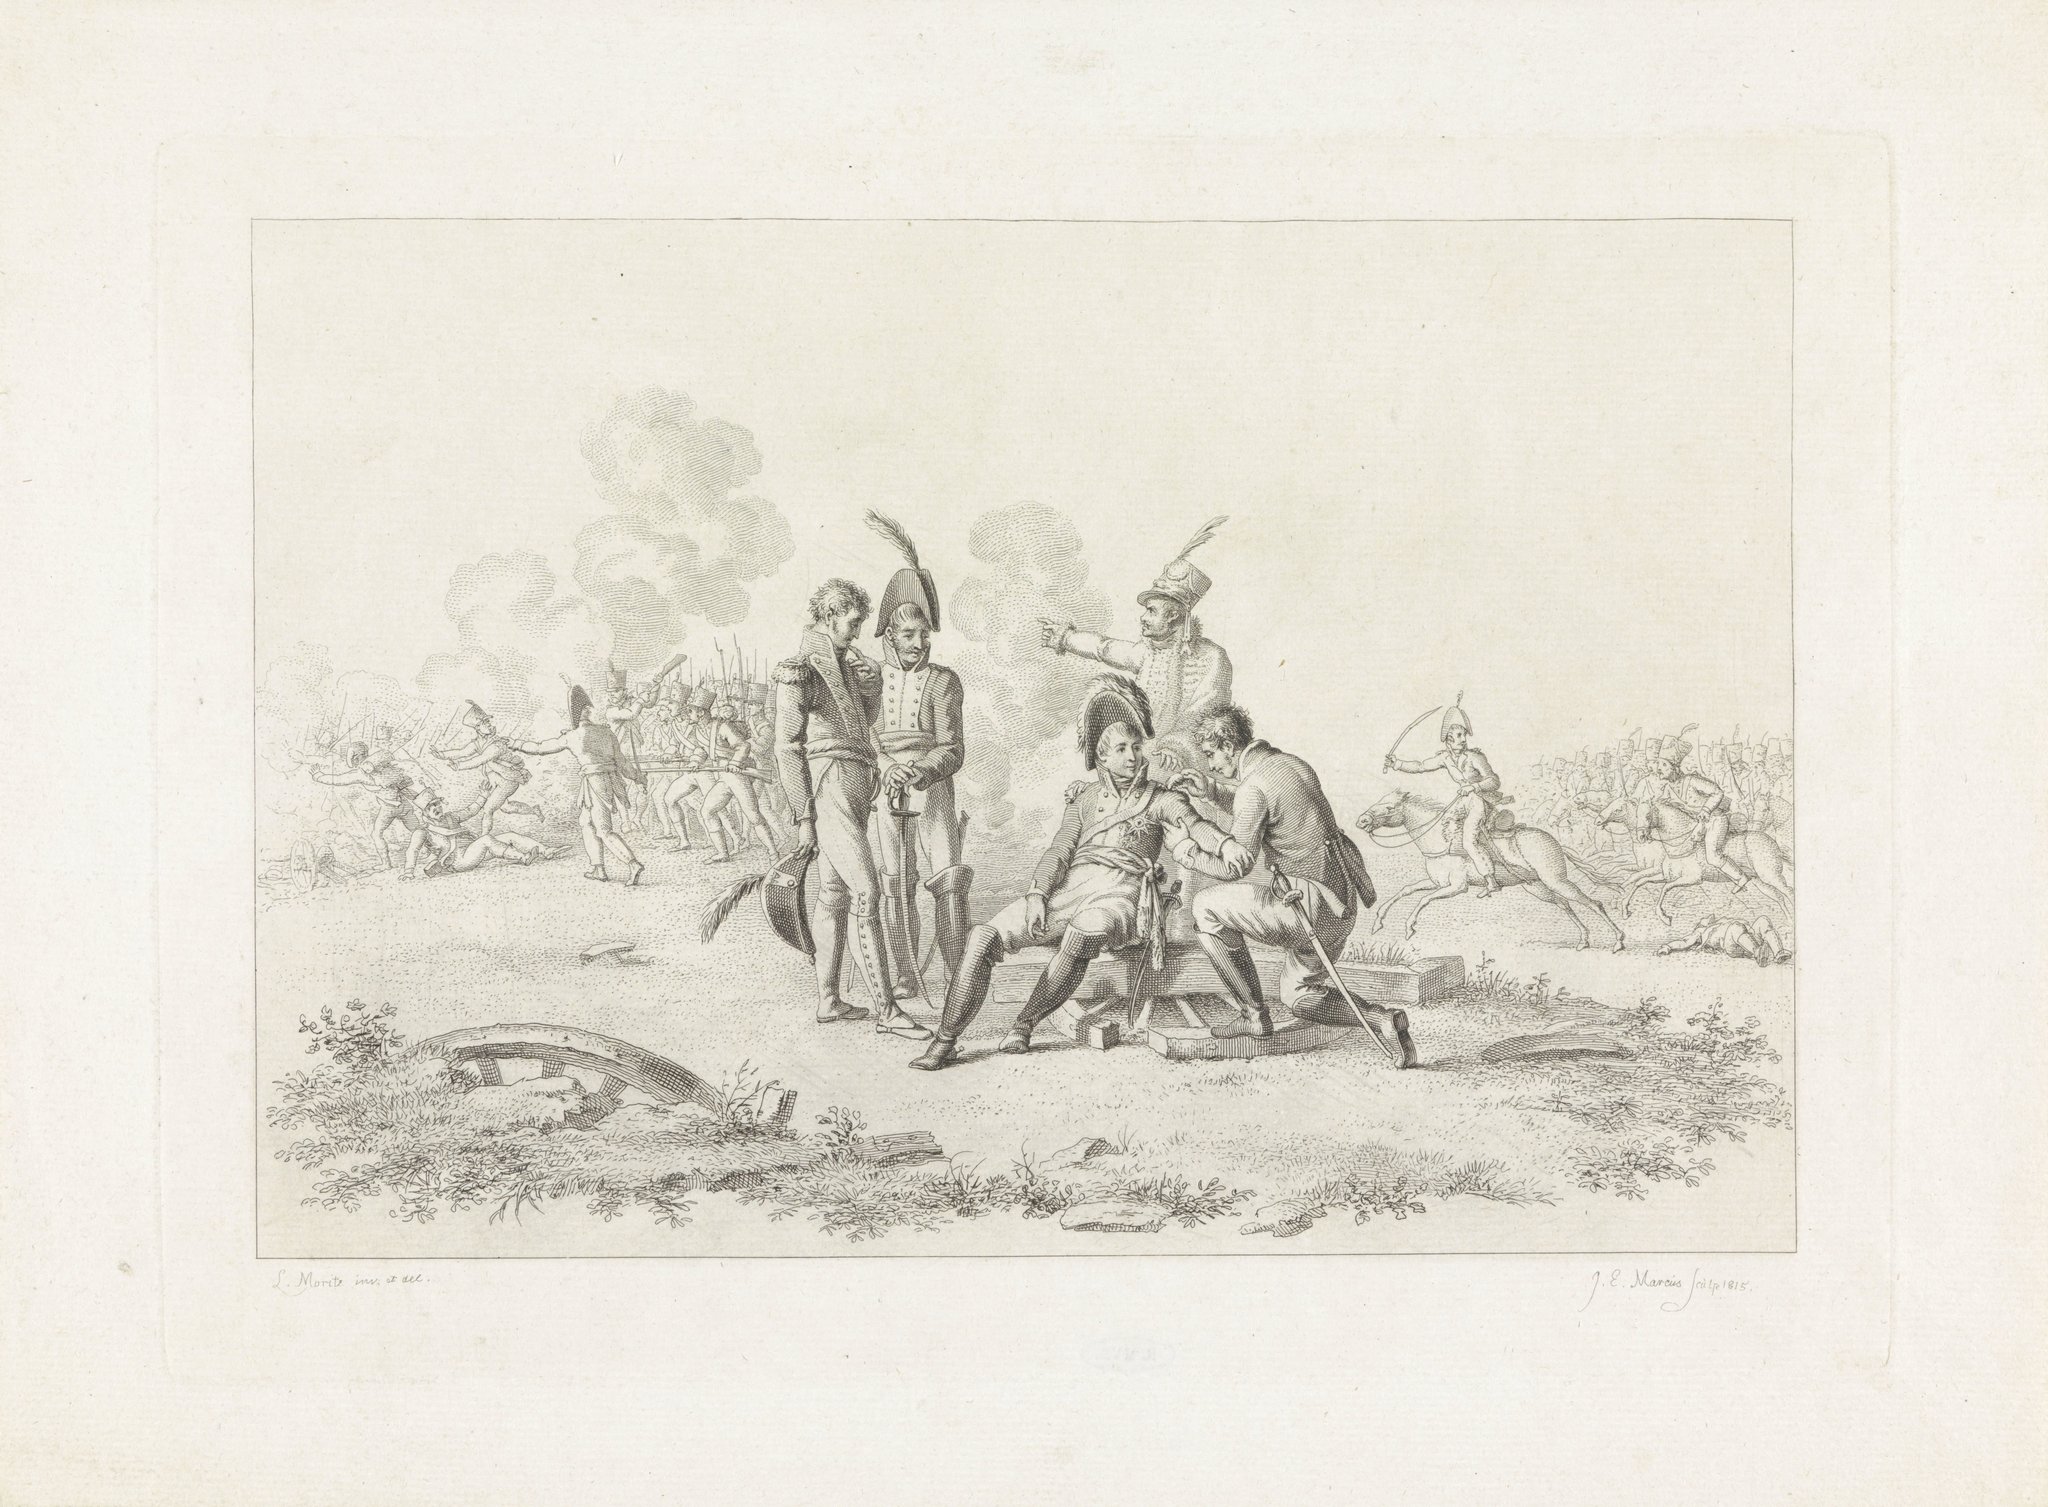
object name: print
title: Prins van Oranje raakt gewond tijdens de slag bij Waterloo, 1815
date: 1815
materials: paper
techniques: engraving, etching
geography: netherlands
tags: the hague, william ii of the netherlands, medical aid and nursing of the sick and wounded on the battlefield, battle (+ land forces), waterloo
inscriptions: collector's mark: Lugt 2228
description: Willem Frederik George, prins van Oranje, tijdens de slag bij Waterloo op 18 juni 1815 gewond geraakt aan de linkerschouder, wordt door een chirurgijn onderzocht. Links en op de achtergrond zware gevechten. Bij de prins staan enkele officieren.